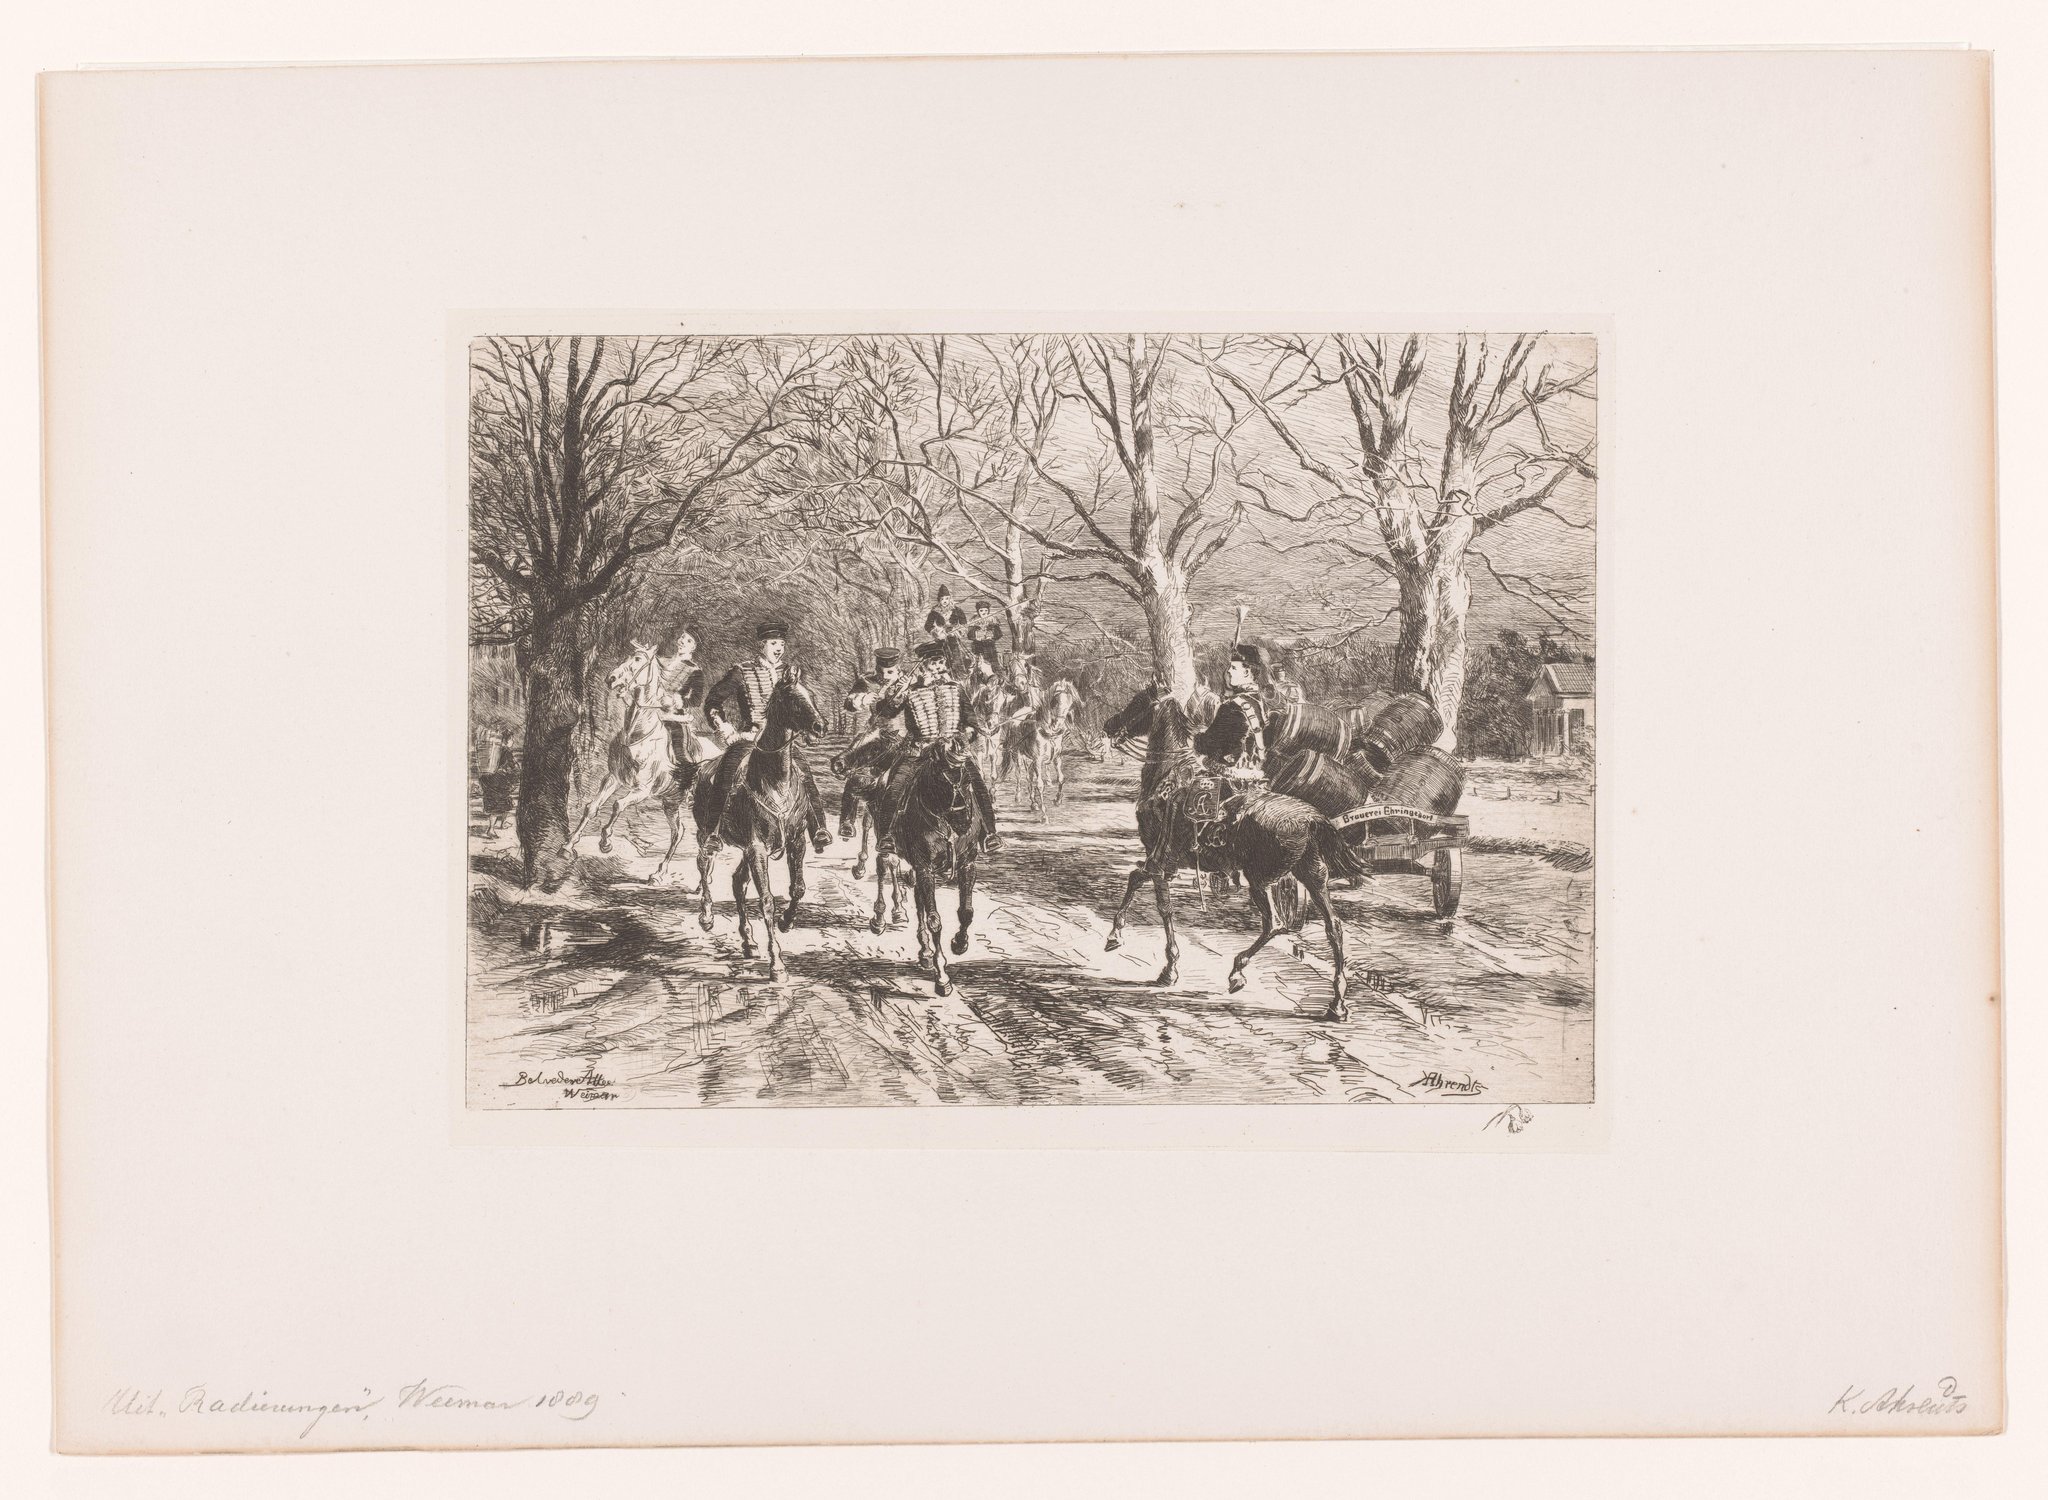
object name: print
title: Belvedere-Allee te Weimar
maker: conrad ahrendts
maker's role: painter, print maker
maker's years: 1855-1901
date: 1889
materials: paper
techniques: etching, intaglio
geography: weimar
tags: private soldier (+ cavalry, horsemen), lane, alley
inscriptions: collector's mark: Lugt 2228, inscription: ‘Uit: "Radierung", Weimar 1889’